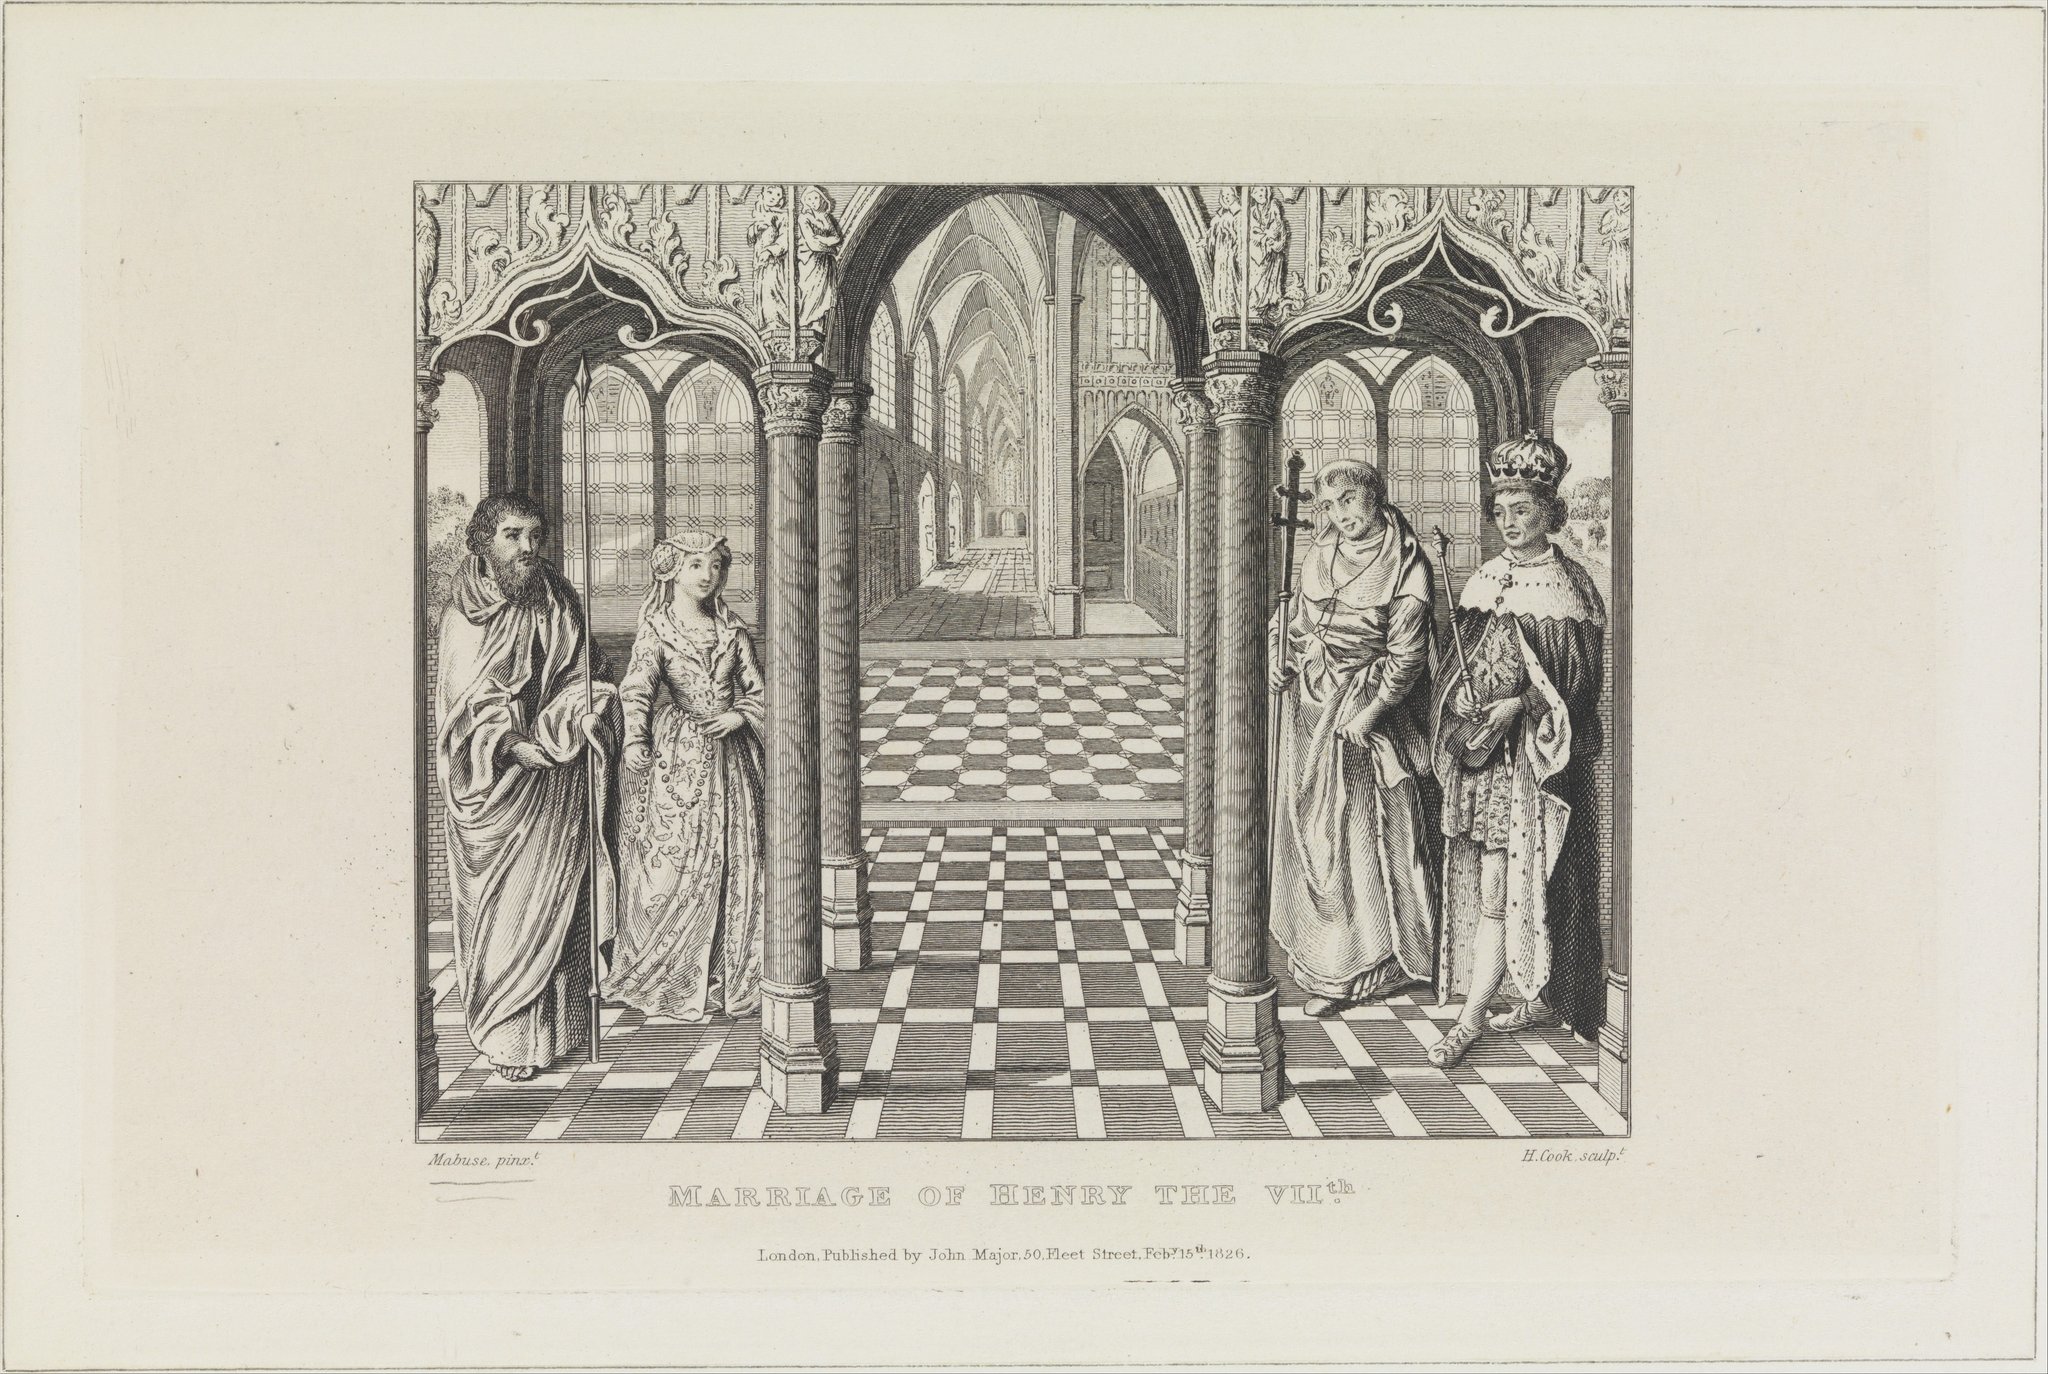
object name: print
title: The Marriage of Henry the VIIth and Elizabeth of York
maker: jan gossart (called mabuse)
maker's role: artist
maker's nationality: netherlandish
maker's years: 1478-1532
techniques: printmaking, engraving, etching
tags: kings,queens